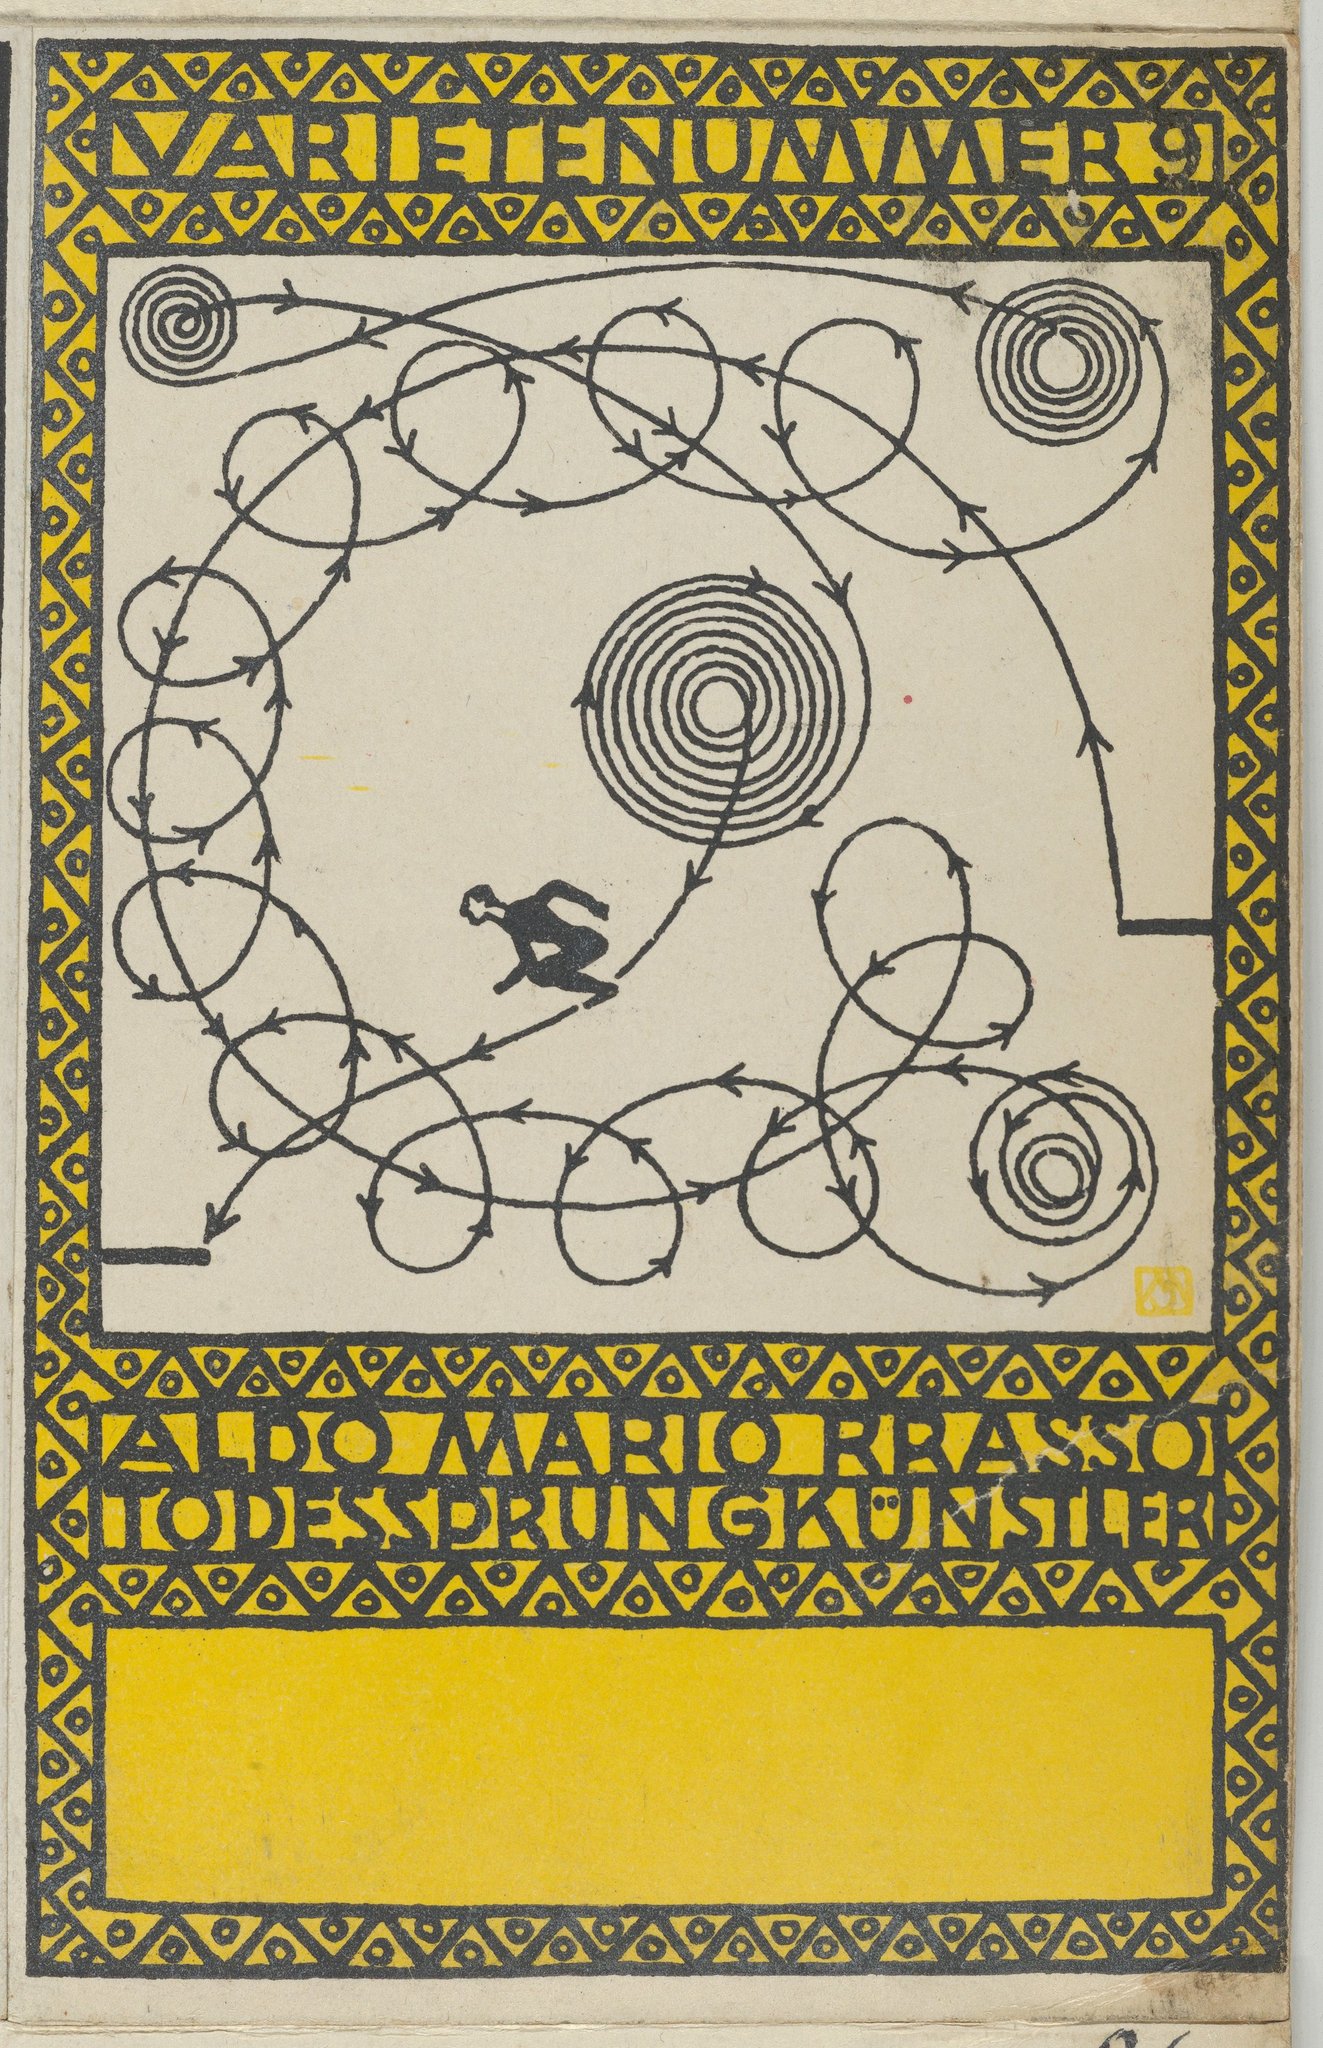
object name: print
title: Variety Act 9: Also Mario Brasso, "Leap of Death" Artist (Varietenummer 9: Aldo Mario Brasso, Todessprungkünstler)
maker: moriz jung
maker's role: artist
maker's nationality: austrian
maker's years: 1885-1915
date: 1907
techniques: lithograph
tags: human figures